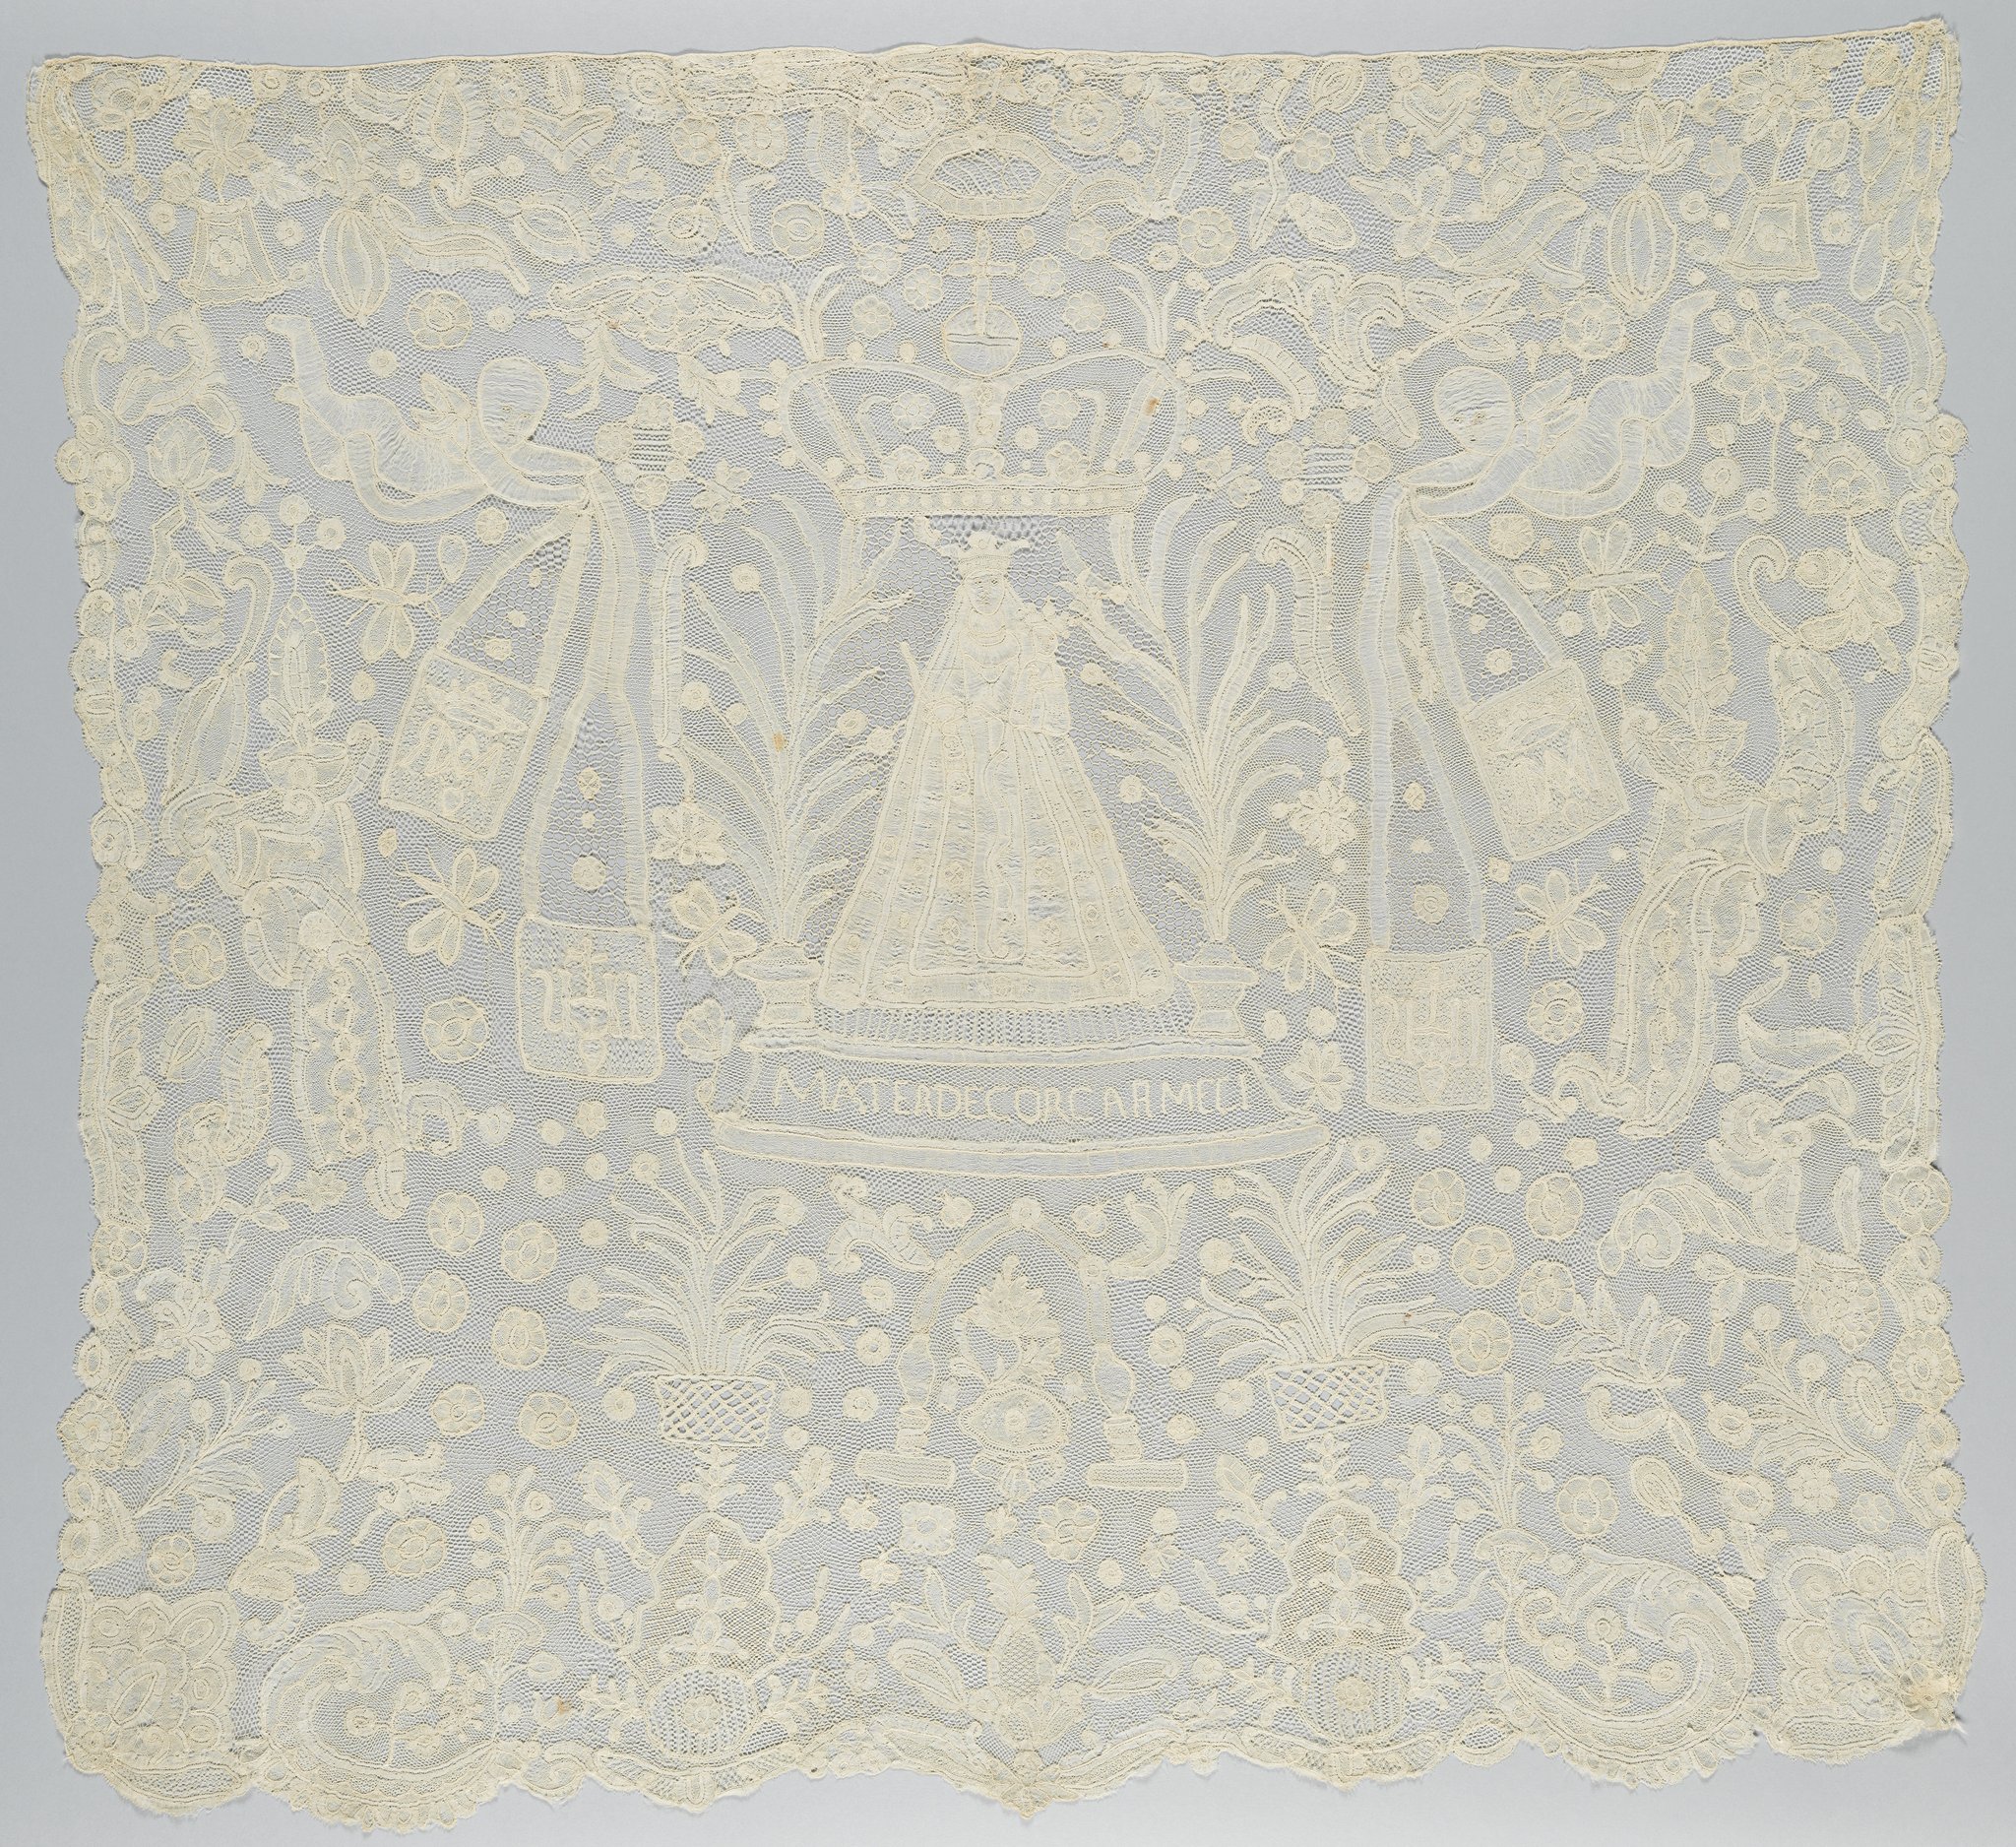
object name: veil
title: Benediction veil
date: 1701-1800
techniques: lace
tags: putti,flowers,virgin mary